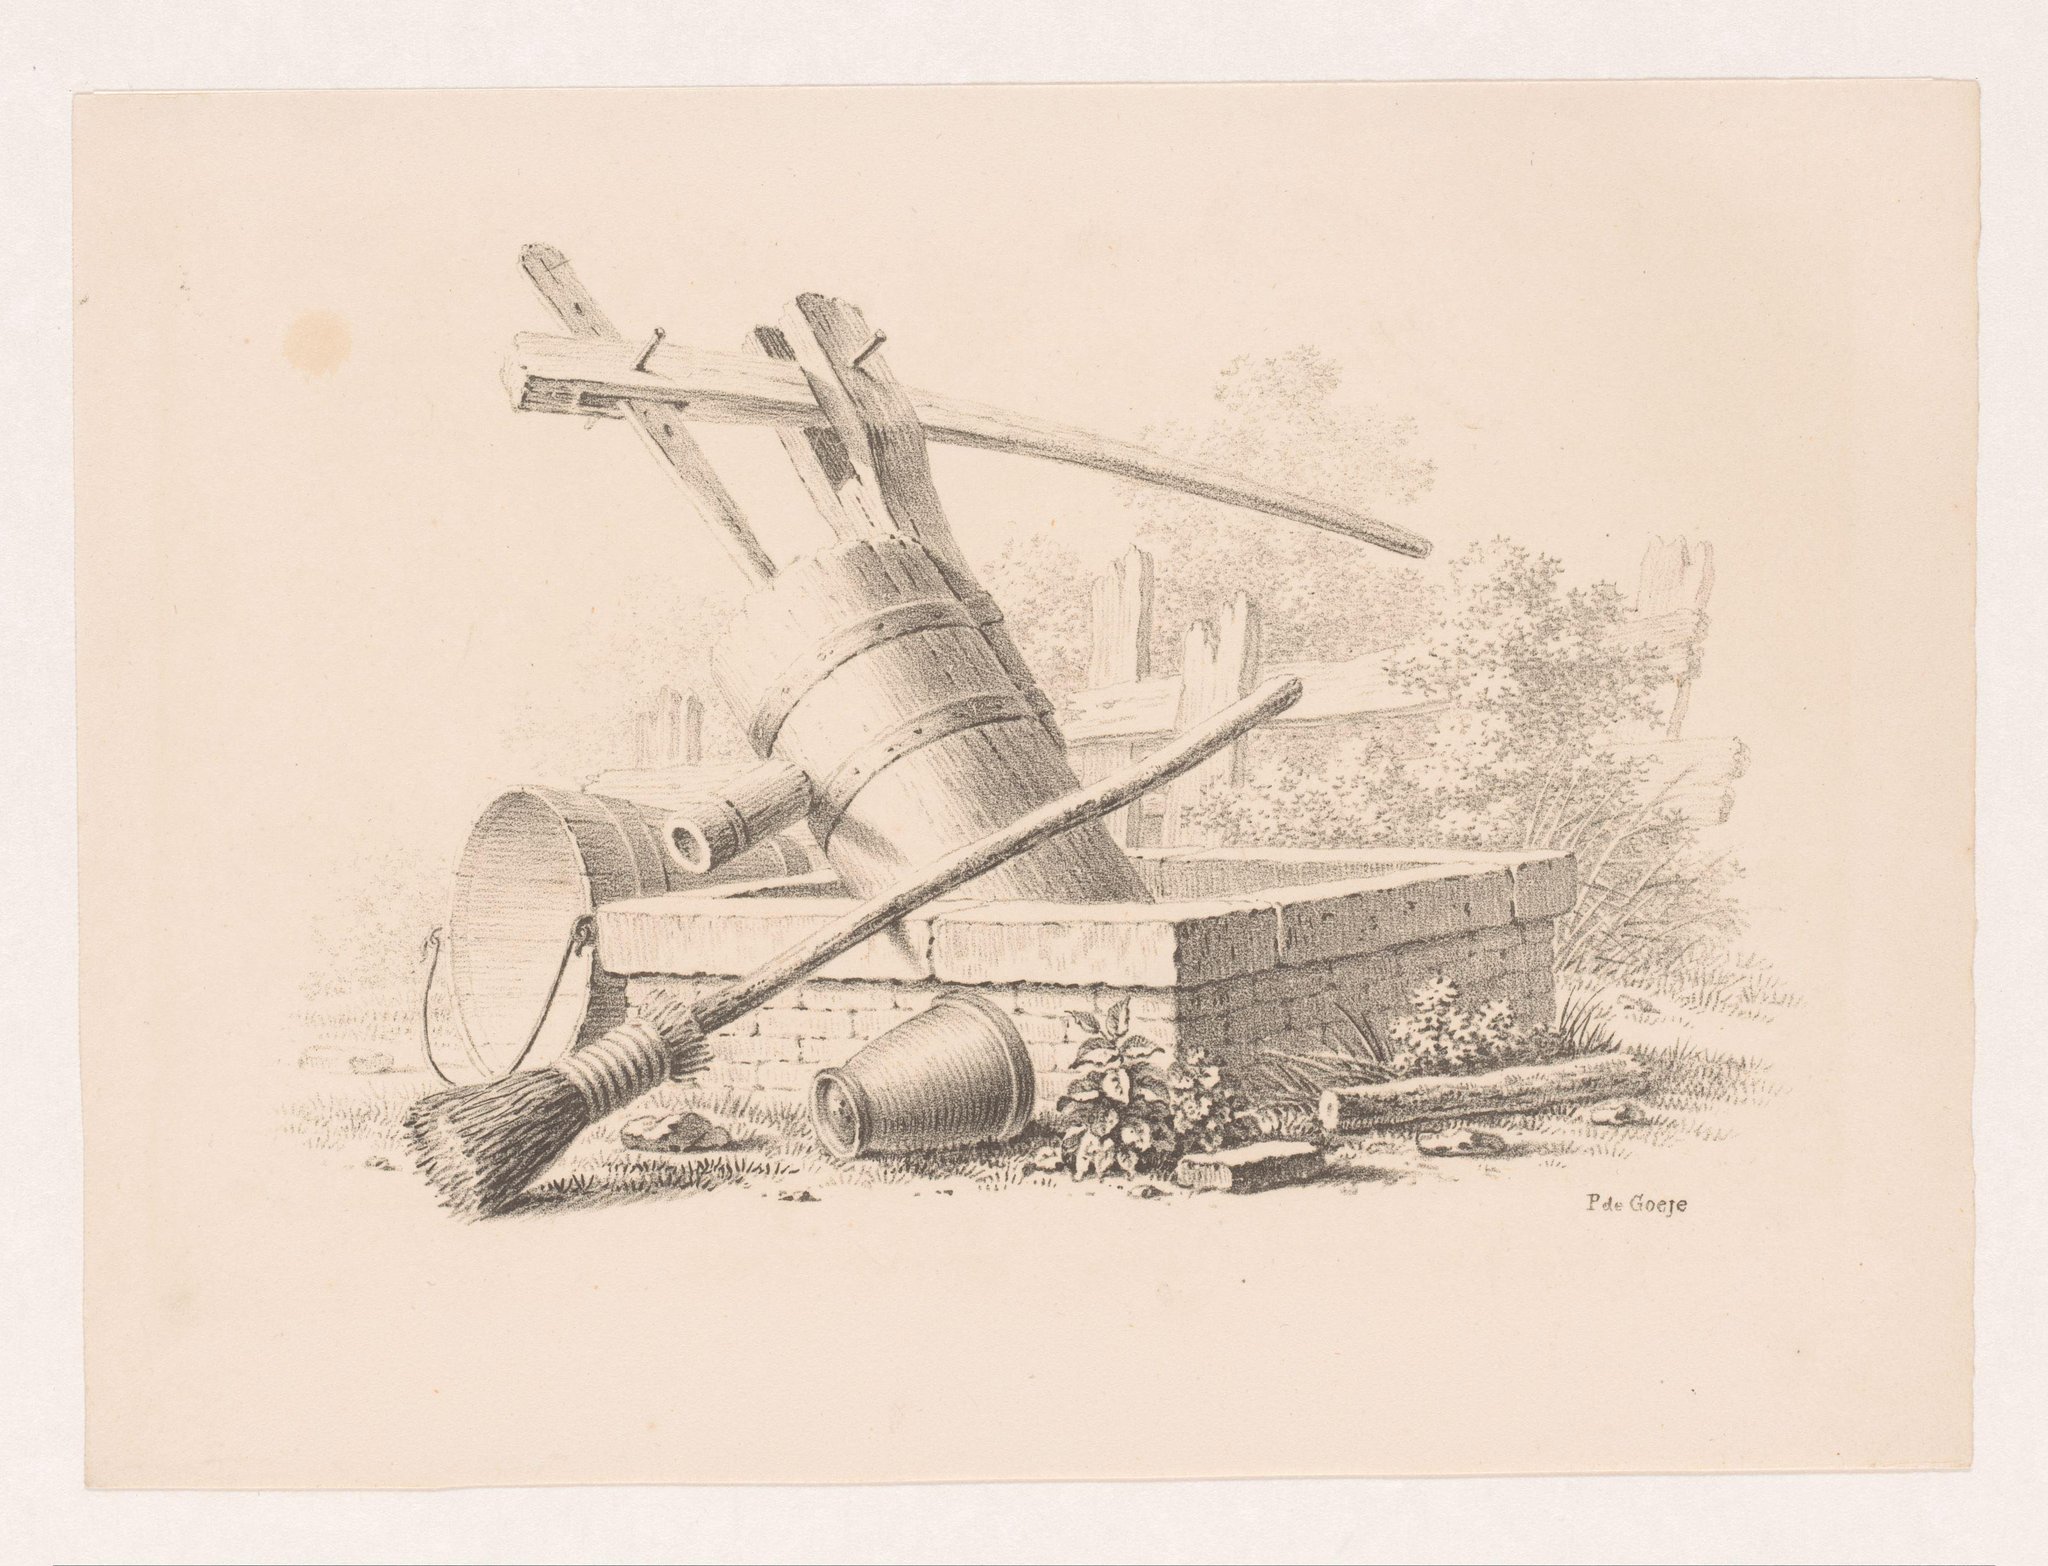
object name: print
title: Waterput in verval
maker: pieter de goeje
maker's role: draughtsman, print maker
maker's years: 1789-1859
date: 1809-1859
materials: paper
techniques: lithograph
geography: netherlands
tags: well, wooden container: barrel, cask, bucket, (household) utensils and implements (with name)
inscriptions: collector's mark: Lugt 2228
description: De houten pomp is omgevallen in de vierkante stenen put. Ernaast liggen een bezem en twee emmers.